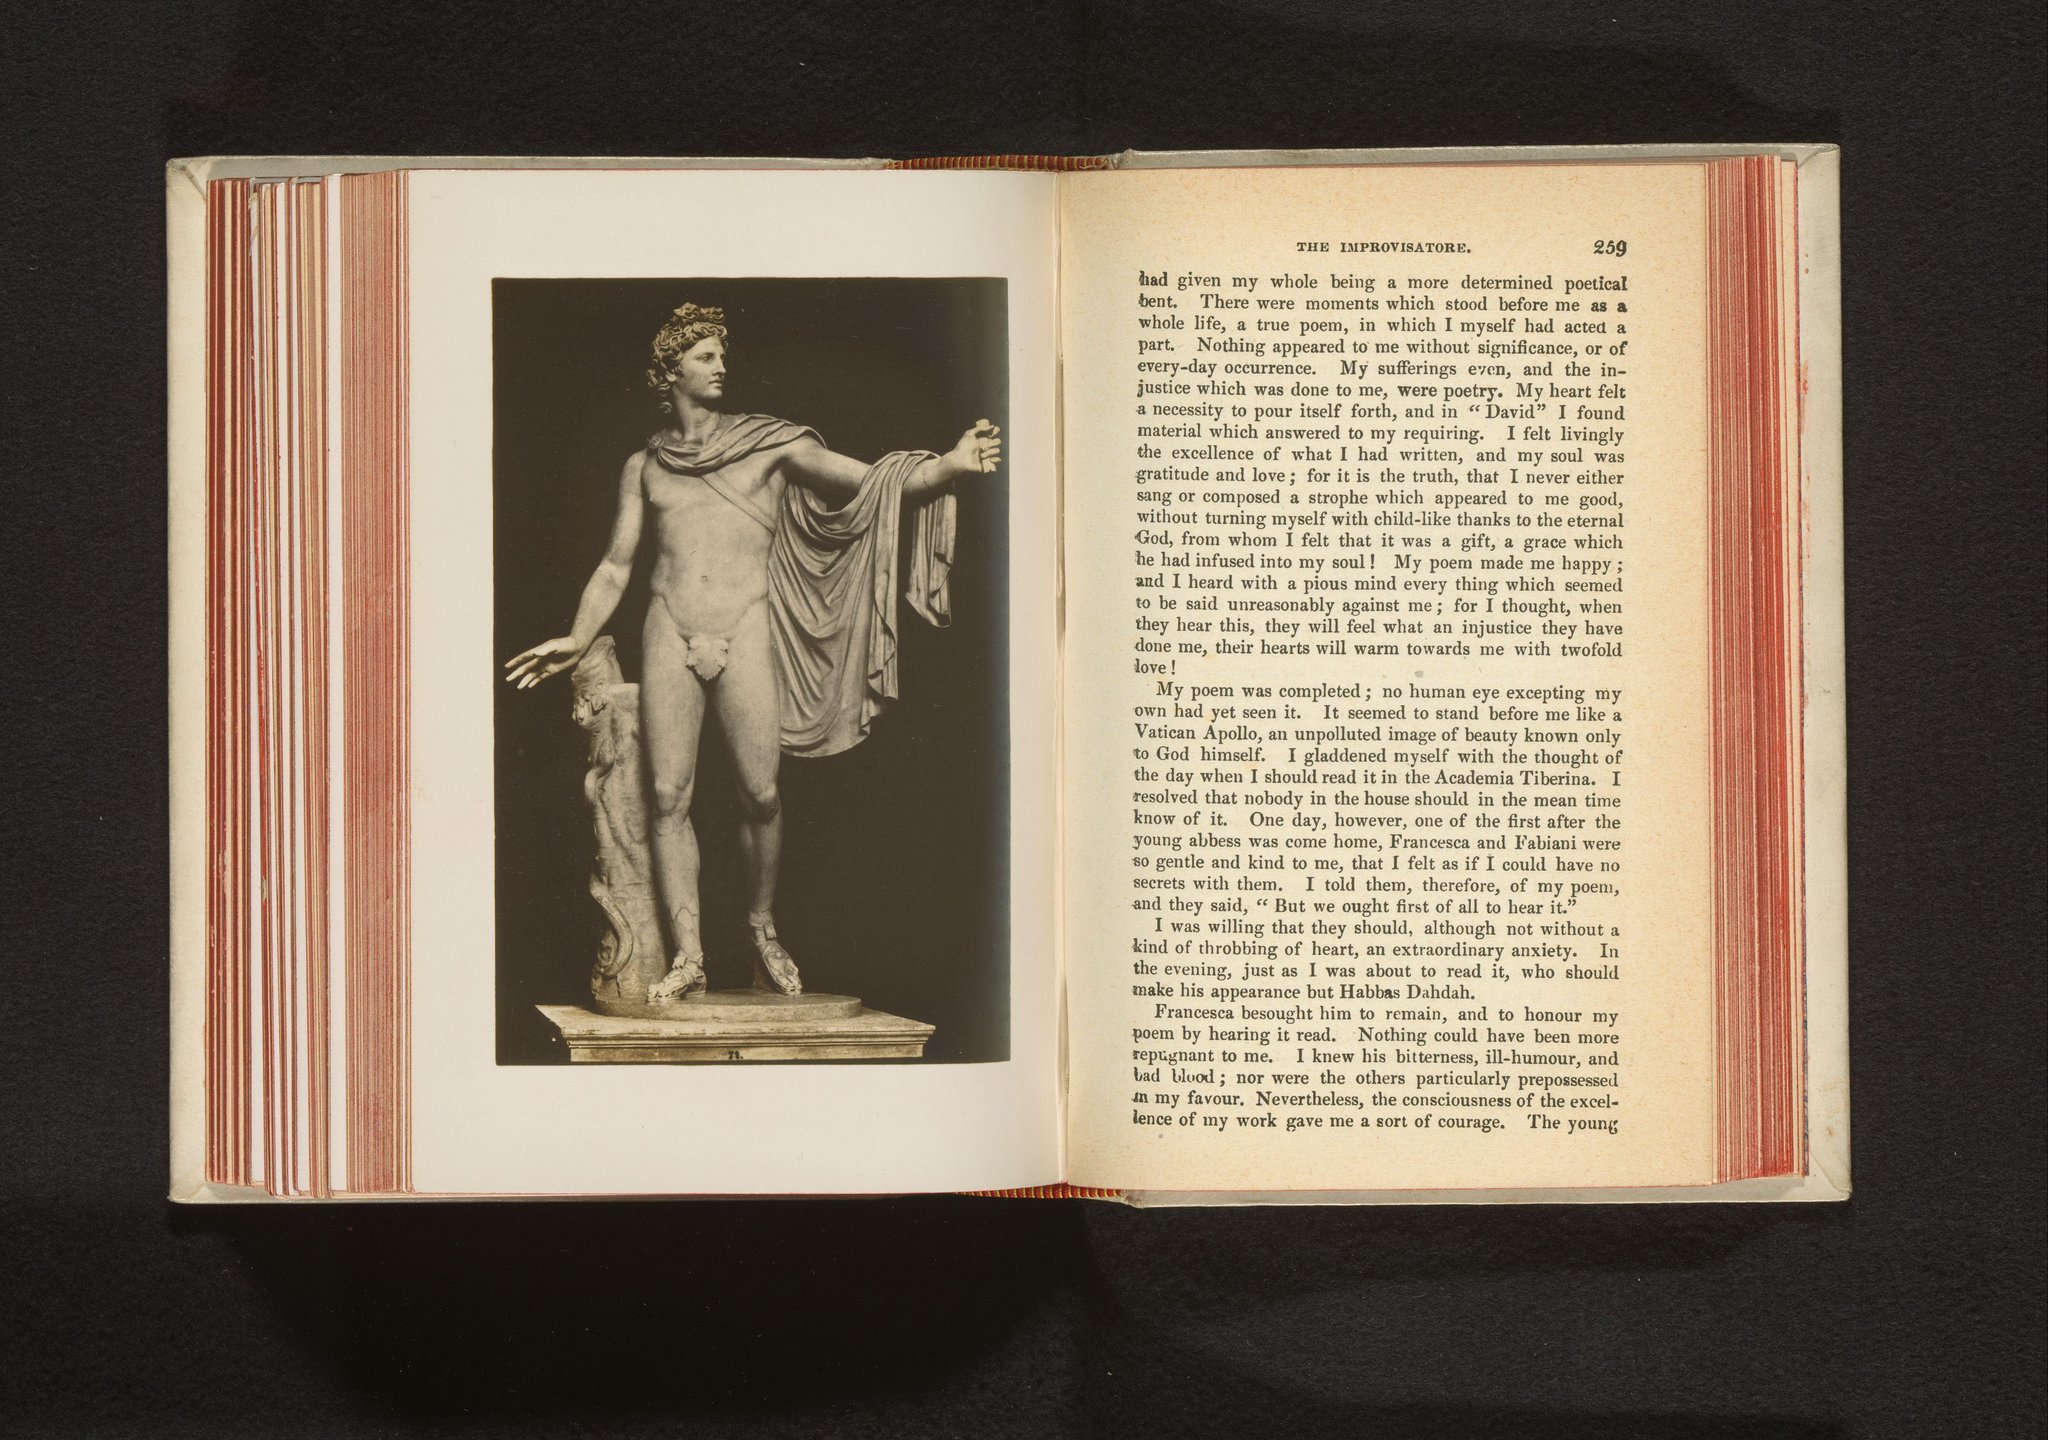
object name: page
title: Apollo van Belvedère in de Vaticaanse Musea te Vaticaanstad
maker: Anonymous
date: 1870-1880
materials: photographic support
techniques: gelatin silver print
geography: vatican museums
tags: (story of) apollo (phoebus), sculpture